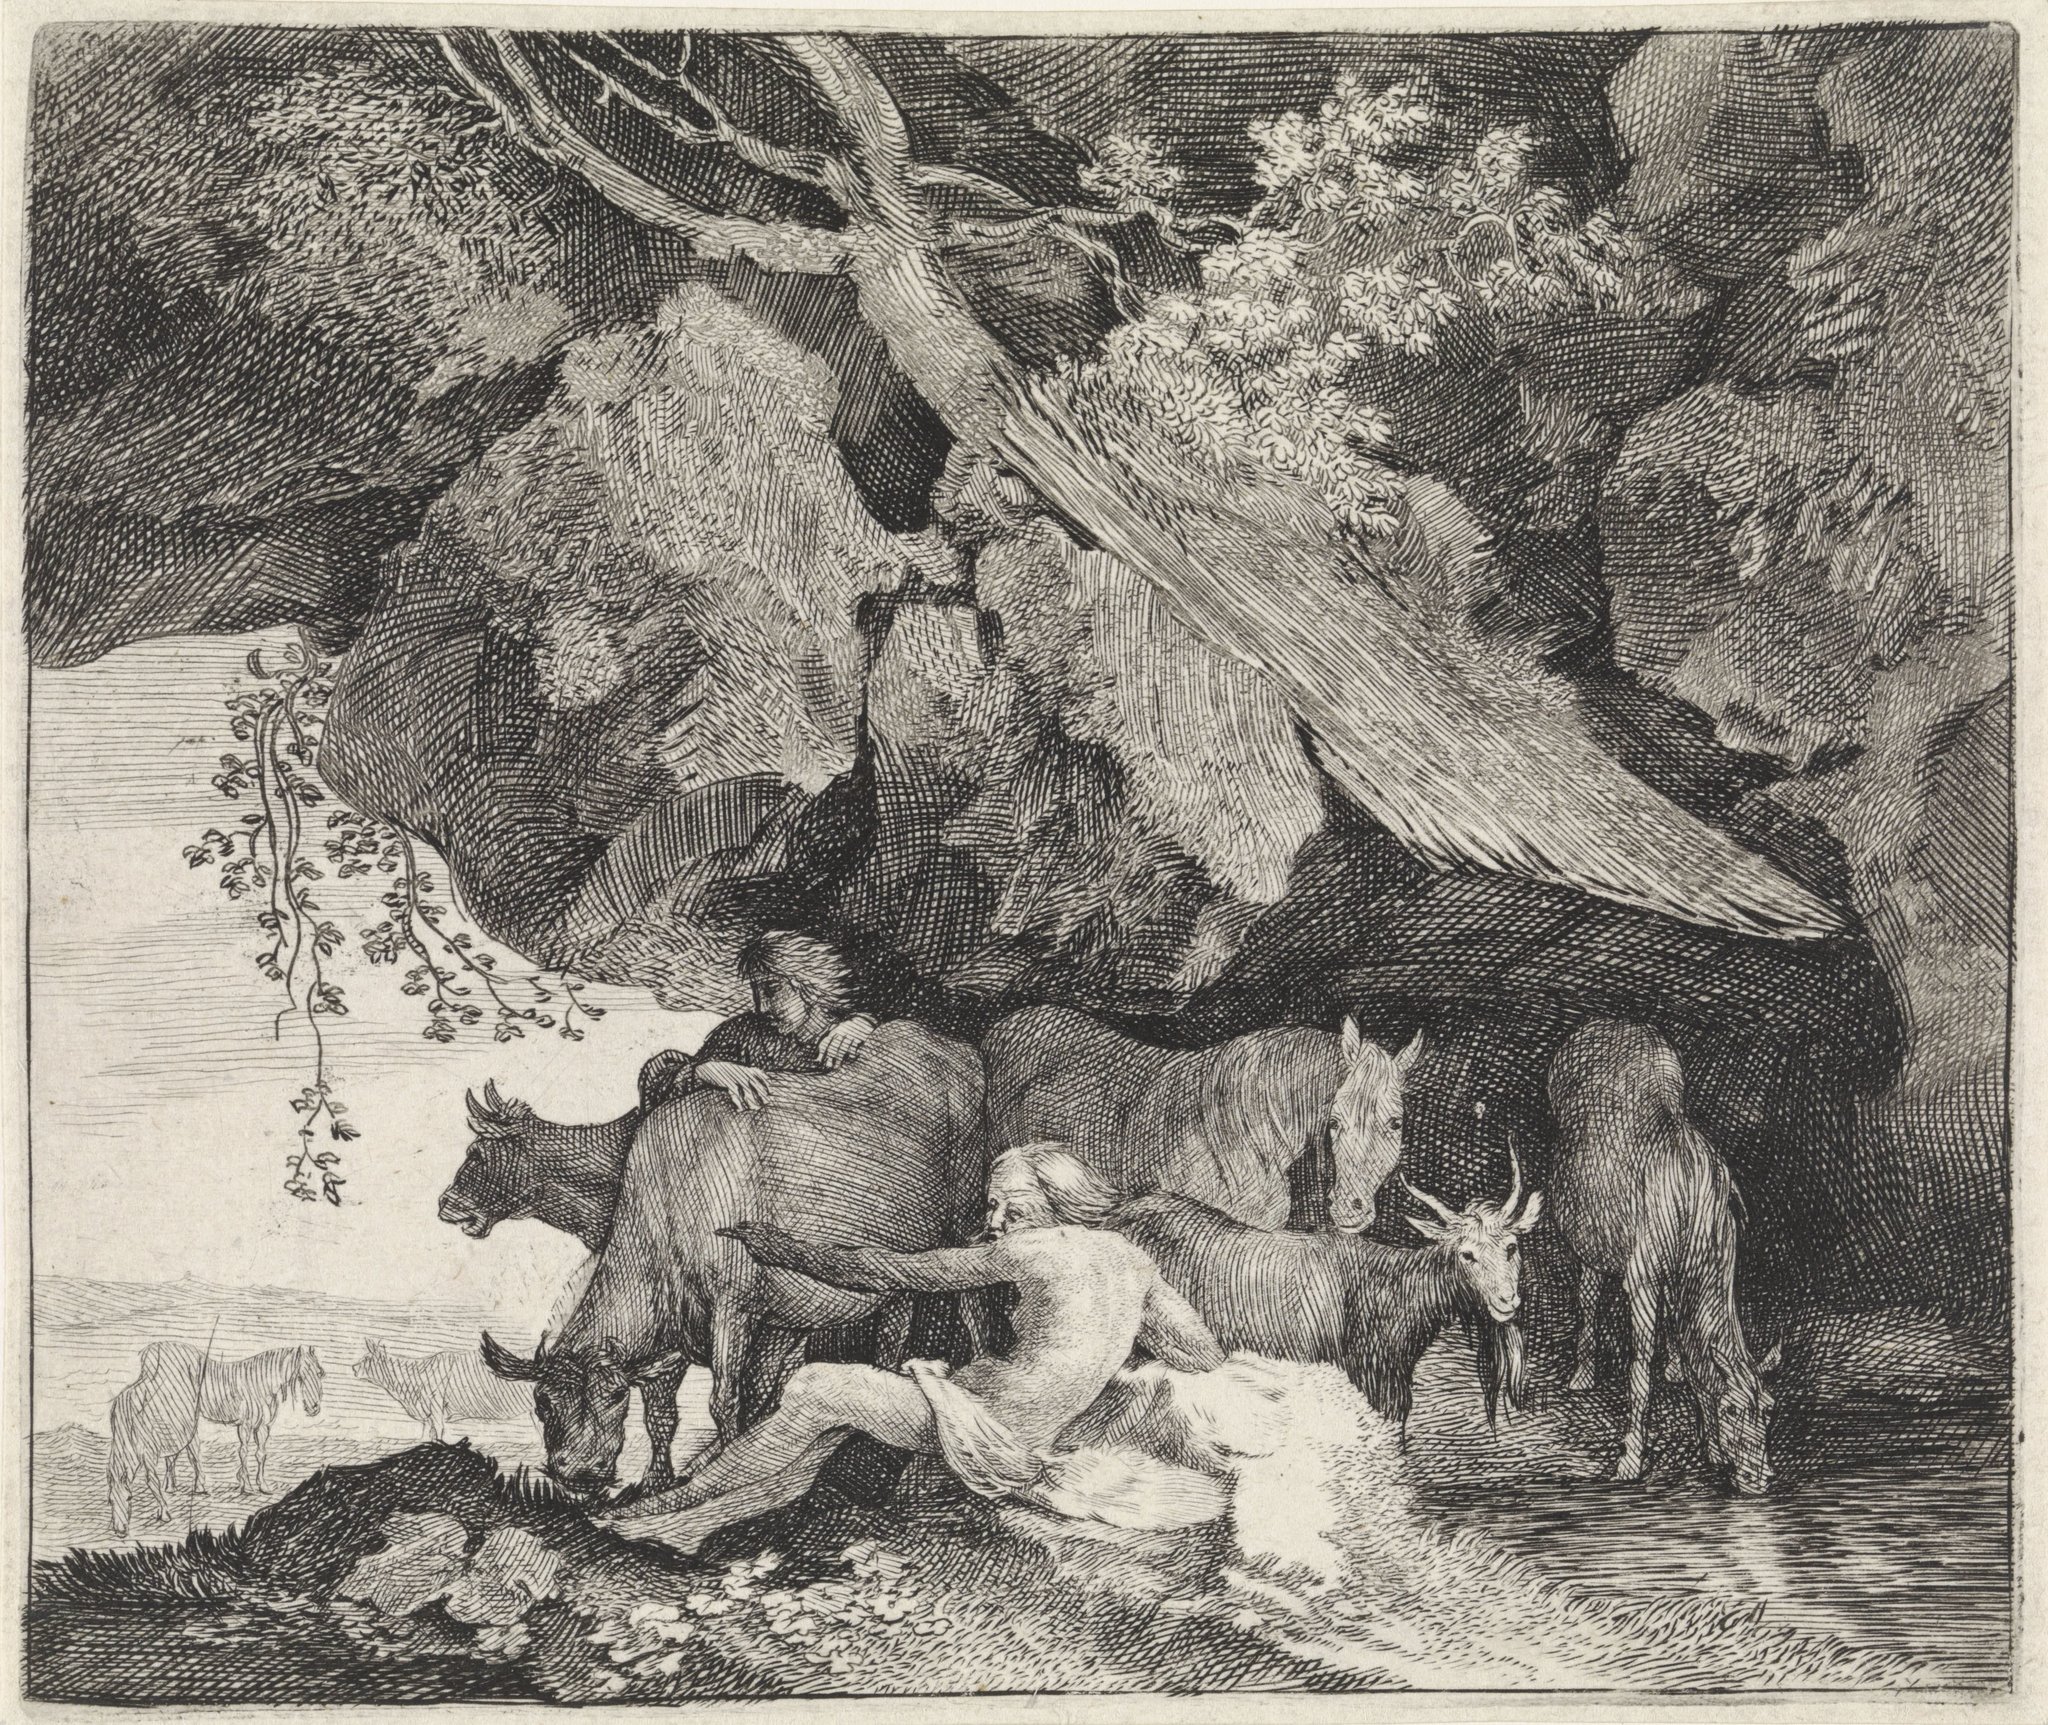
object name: print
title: Battus onthult waar Mercurius de kudde van Apollo verstopt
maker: moyses van wtenbrouck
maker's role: painter, print maker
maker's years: 1590-1647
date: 1600-1647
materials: paper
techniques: engraving, etching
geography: the hague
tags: mercury steals the flock which apollo is tending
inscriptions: collector's mark: Lugt 240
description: Battus ligt half opgericht op de grond en wijst met gestrekte arm. Achter hem staat een kudde vee. De vermomde Mercurius leunt op een koe. Scène uit Ovidius’ Metamorfosen (Met. II, 703).